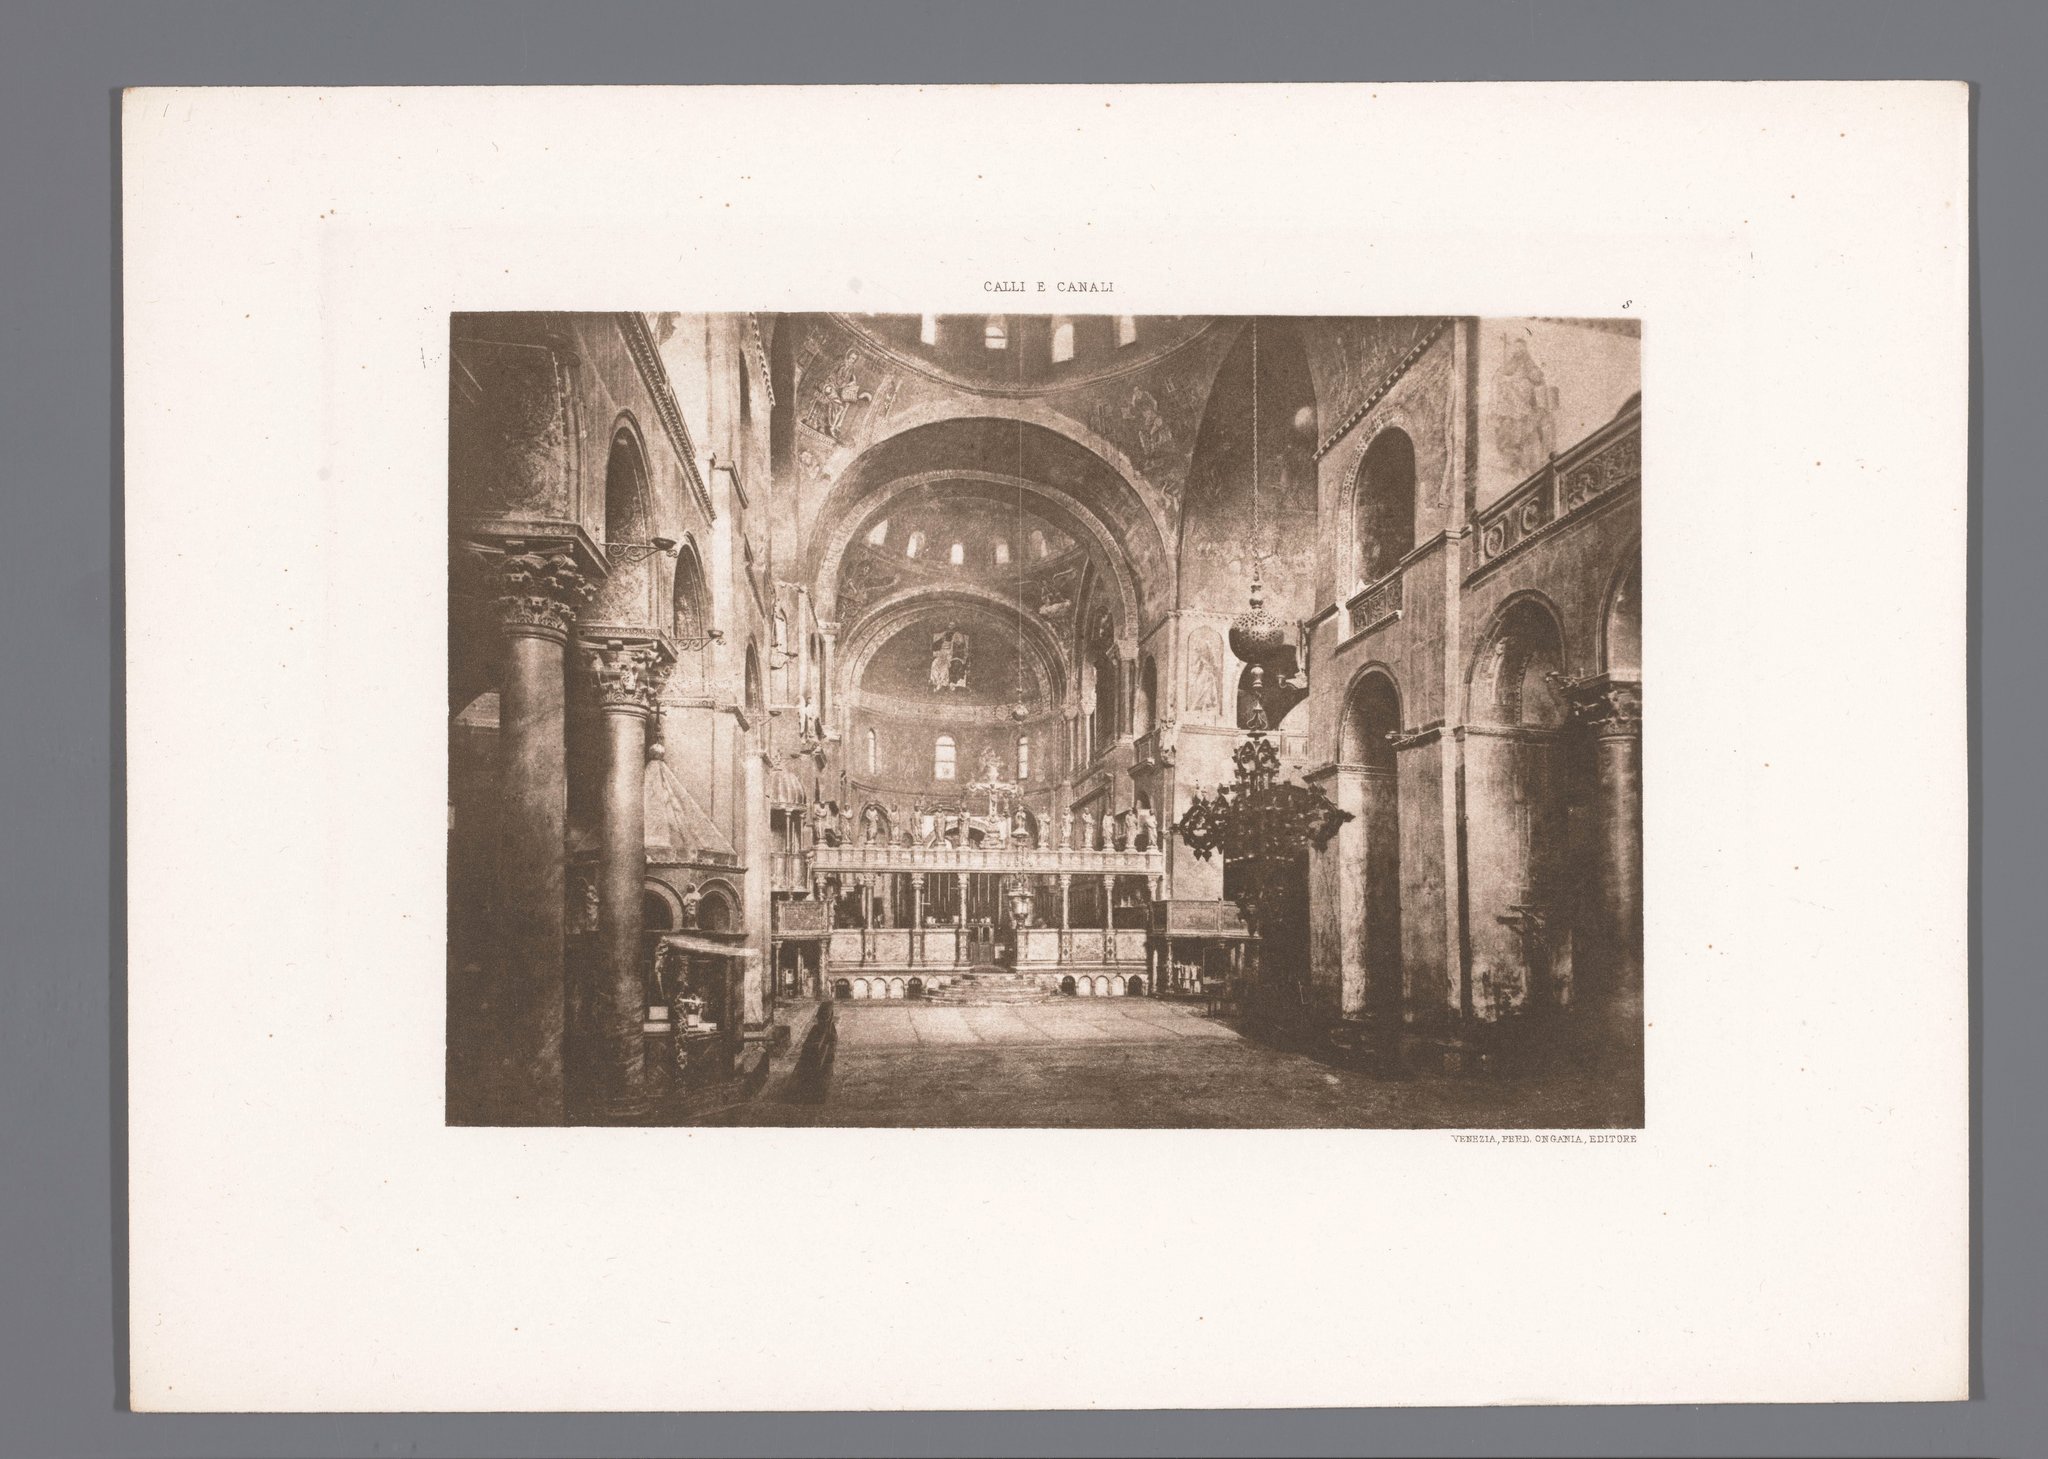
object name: page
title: Calli e canali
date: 1888-1898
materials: paper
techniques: photoaquatint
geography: venice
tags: interior of church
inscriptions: inscription: ‘s’